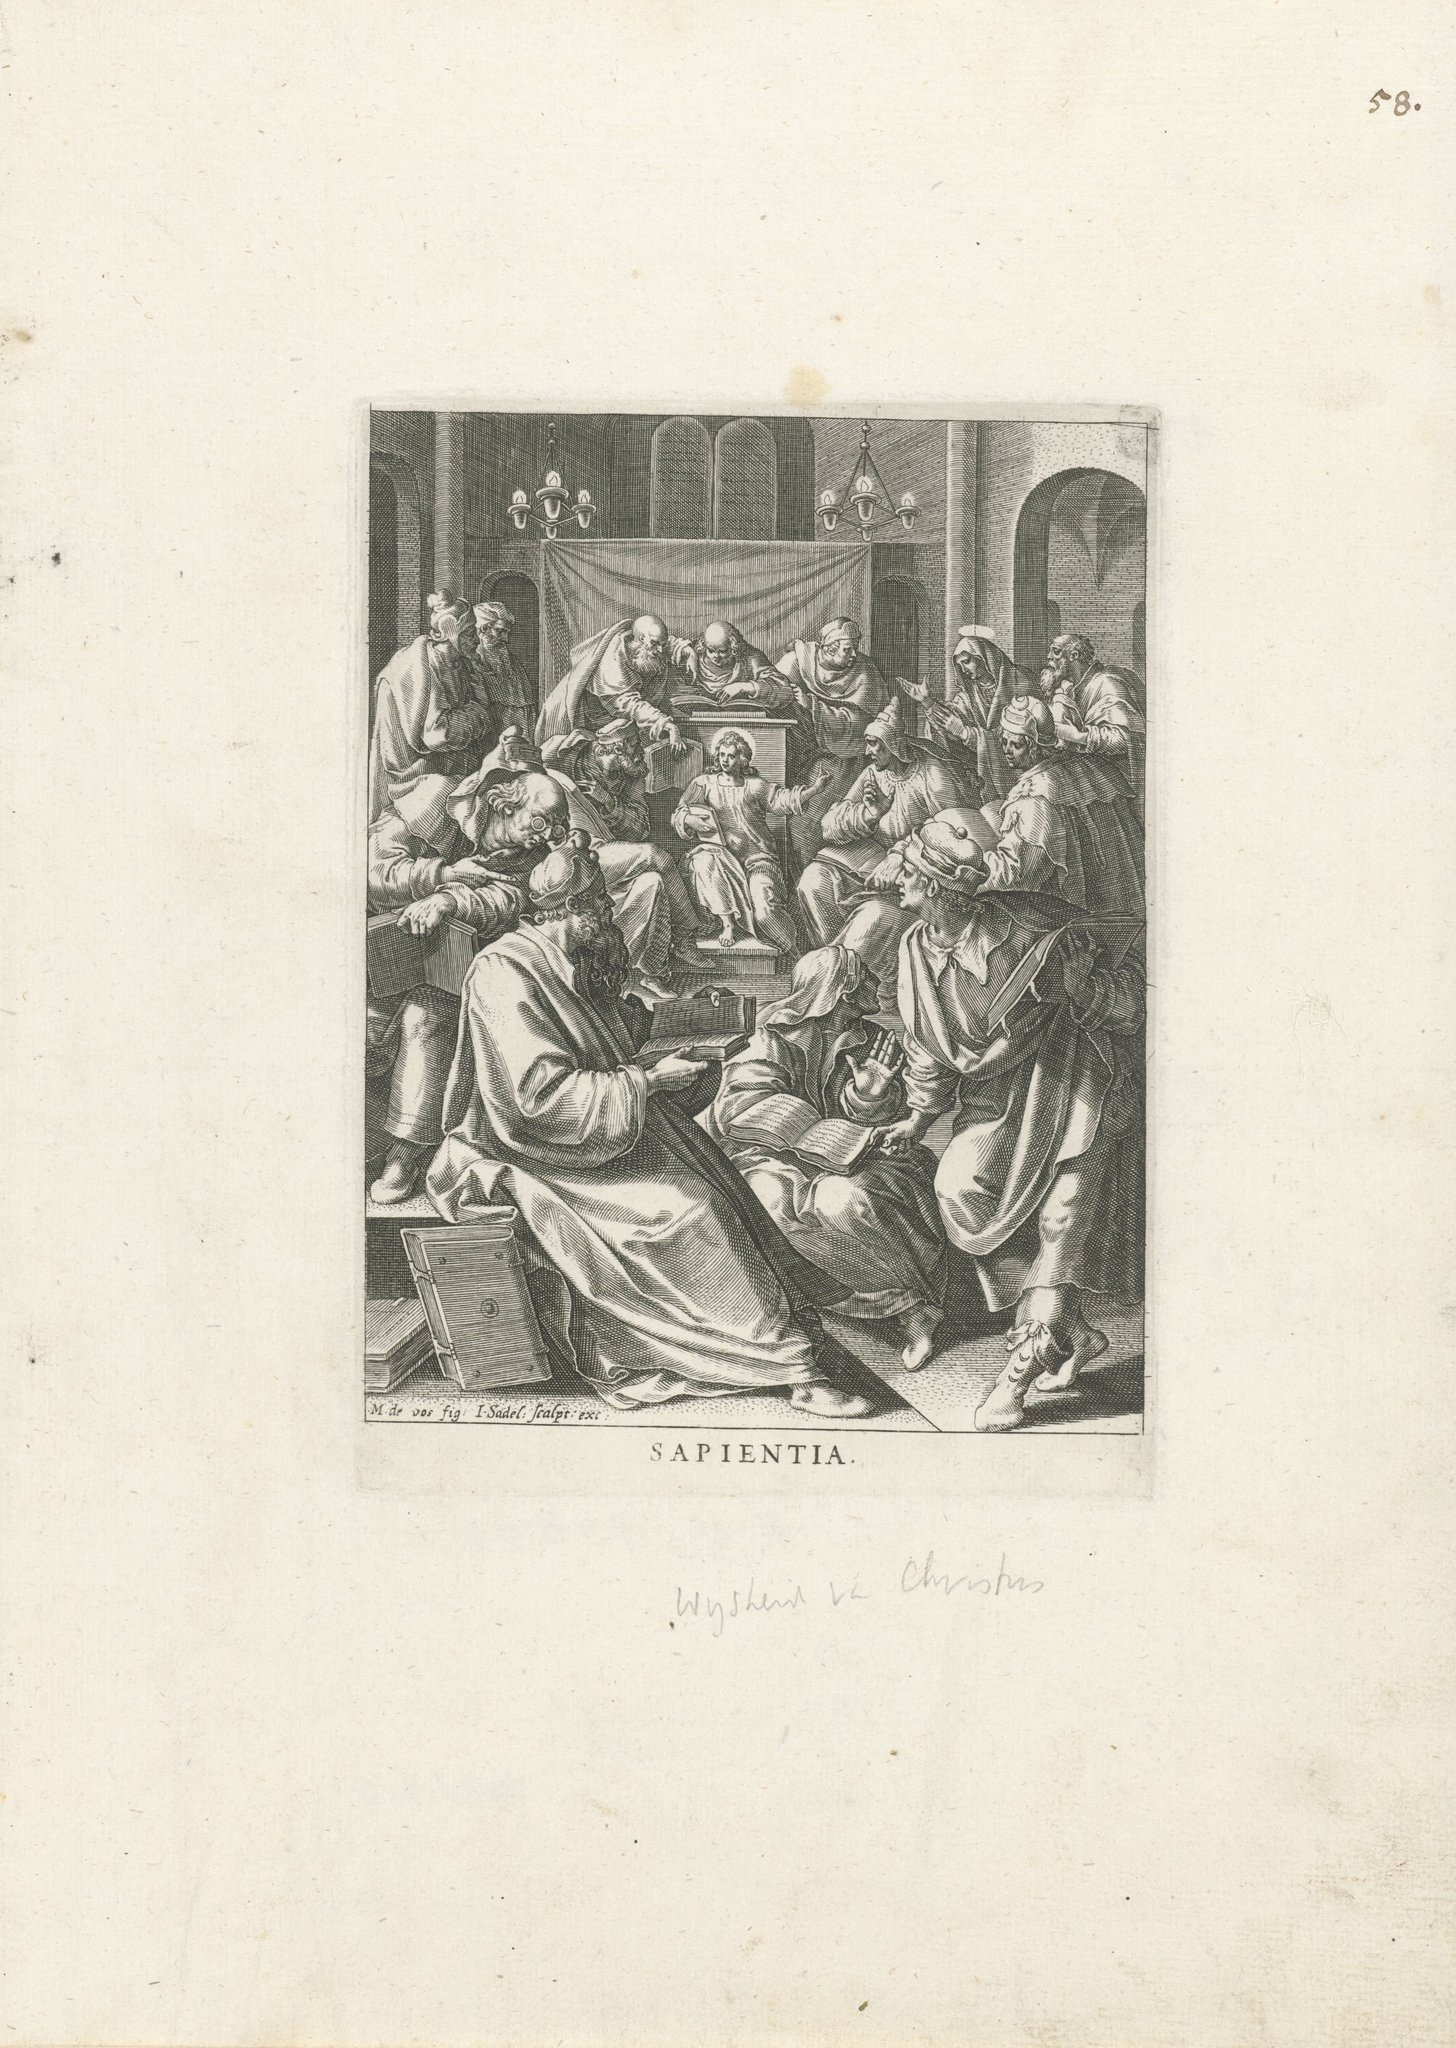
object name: print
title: Christus te midden van de leraren: wijsheid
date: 1585-1588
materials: paper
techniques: engraving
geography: munich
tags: christ's dispute with the doctors in the temple; he counts his arguments on his fingers, wisdom, 'sapientia' ~ one of the seven gifts of the soul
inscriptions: number: ‘58’, collector's mark: Lugt 2228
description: De twaalfjarige Christus tussen de schriftgeleerden in de tempel. De derde prent van een achtdelige serie met scènes uit het leven van Christus die zijn belangrijkste deugden verbeelden.